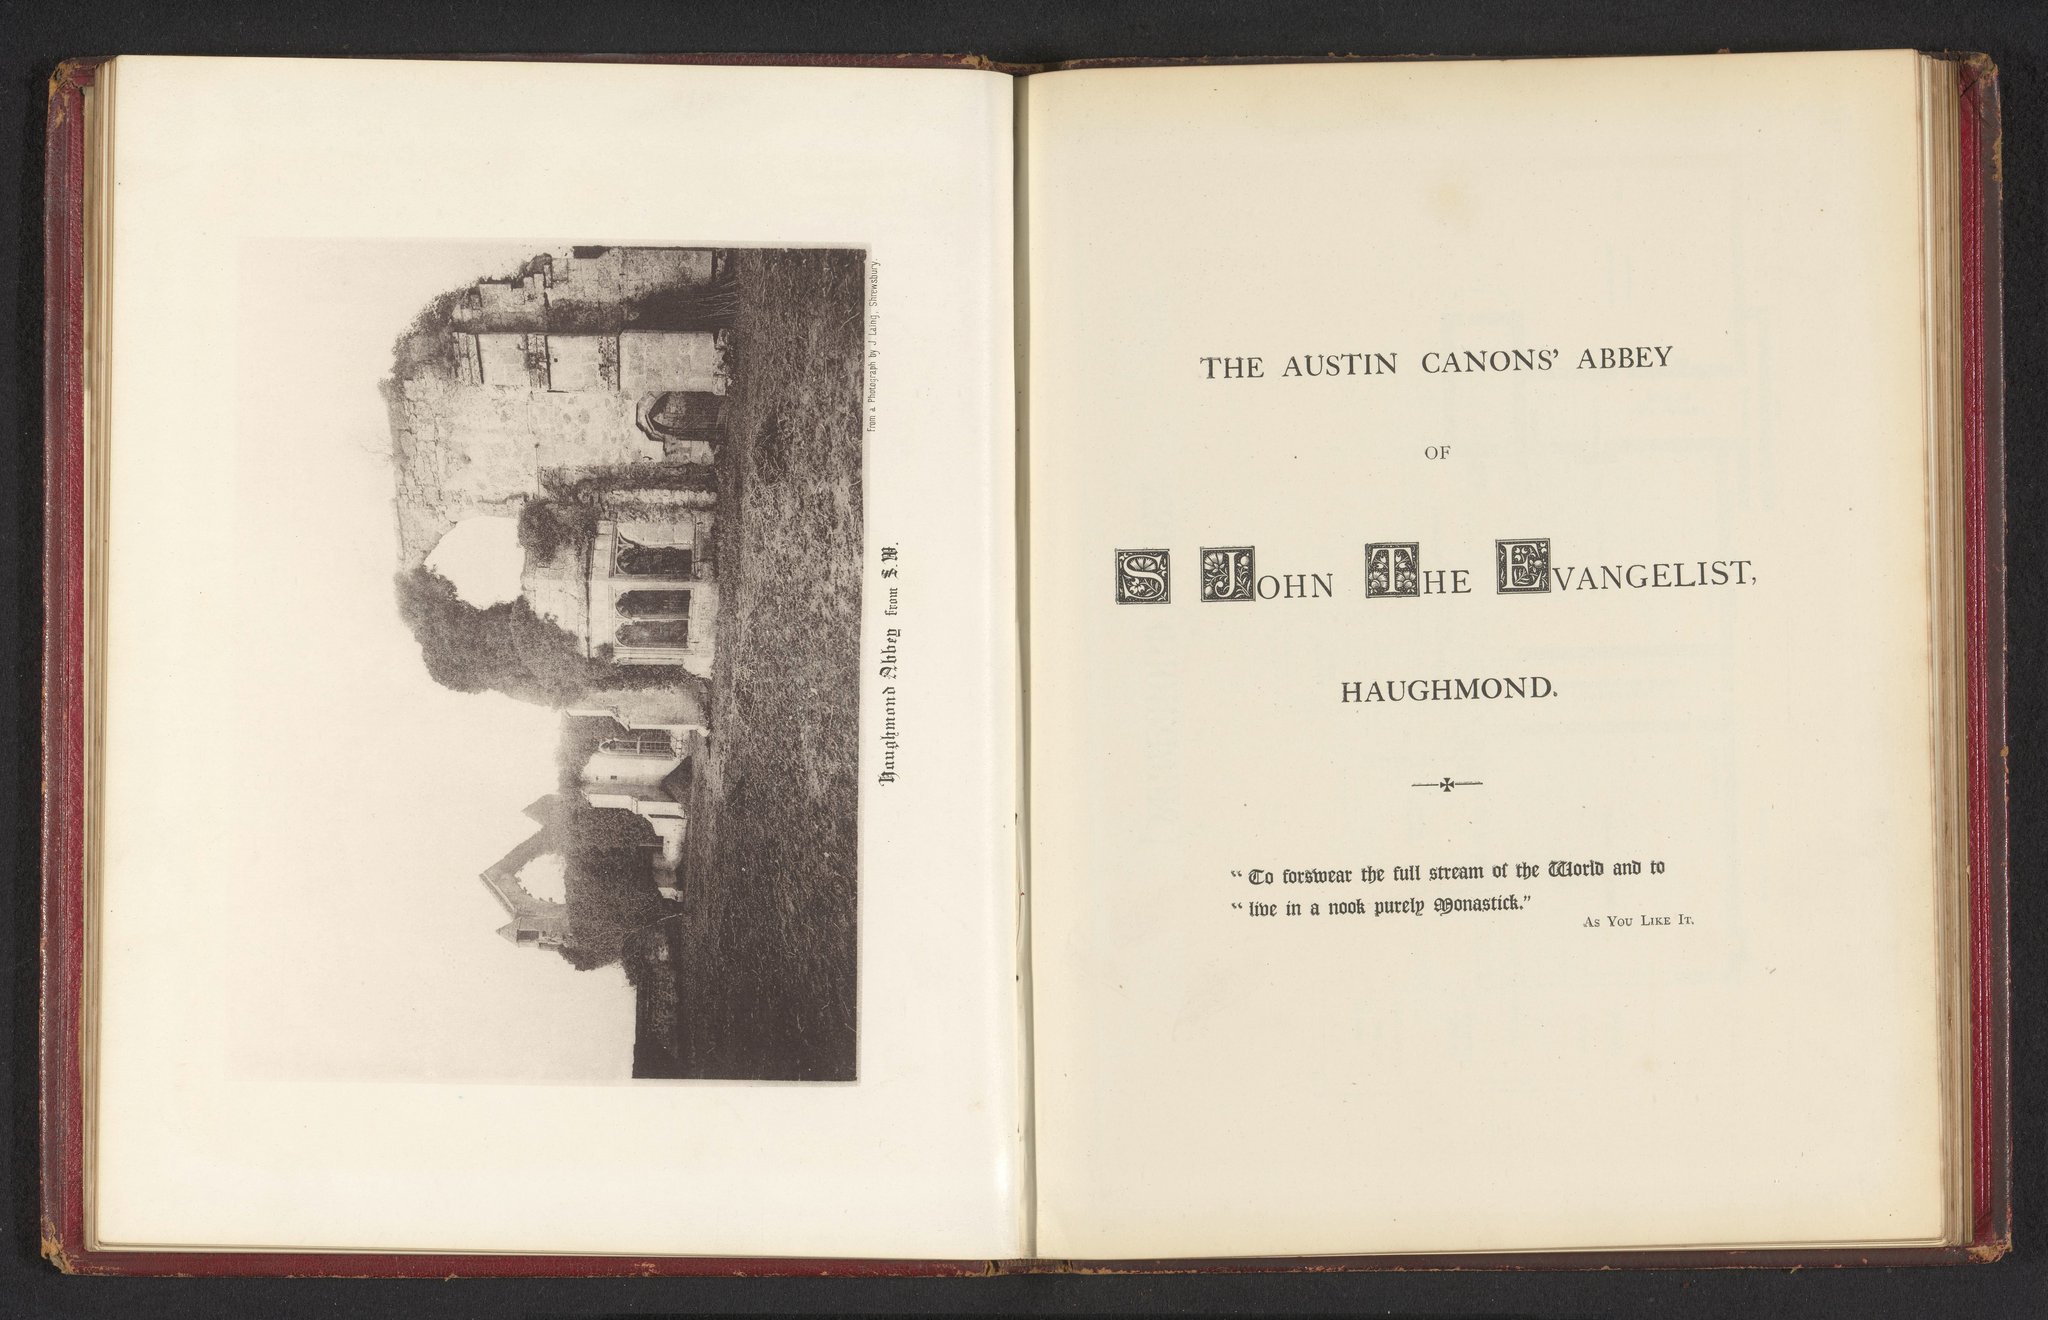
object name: page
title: Gezicht op de ruïne van Haughmond Abbey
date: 1867-1877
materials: paper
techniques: photograph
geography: haughmond abbey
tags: ruin of church, monastery, etc.